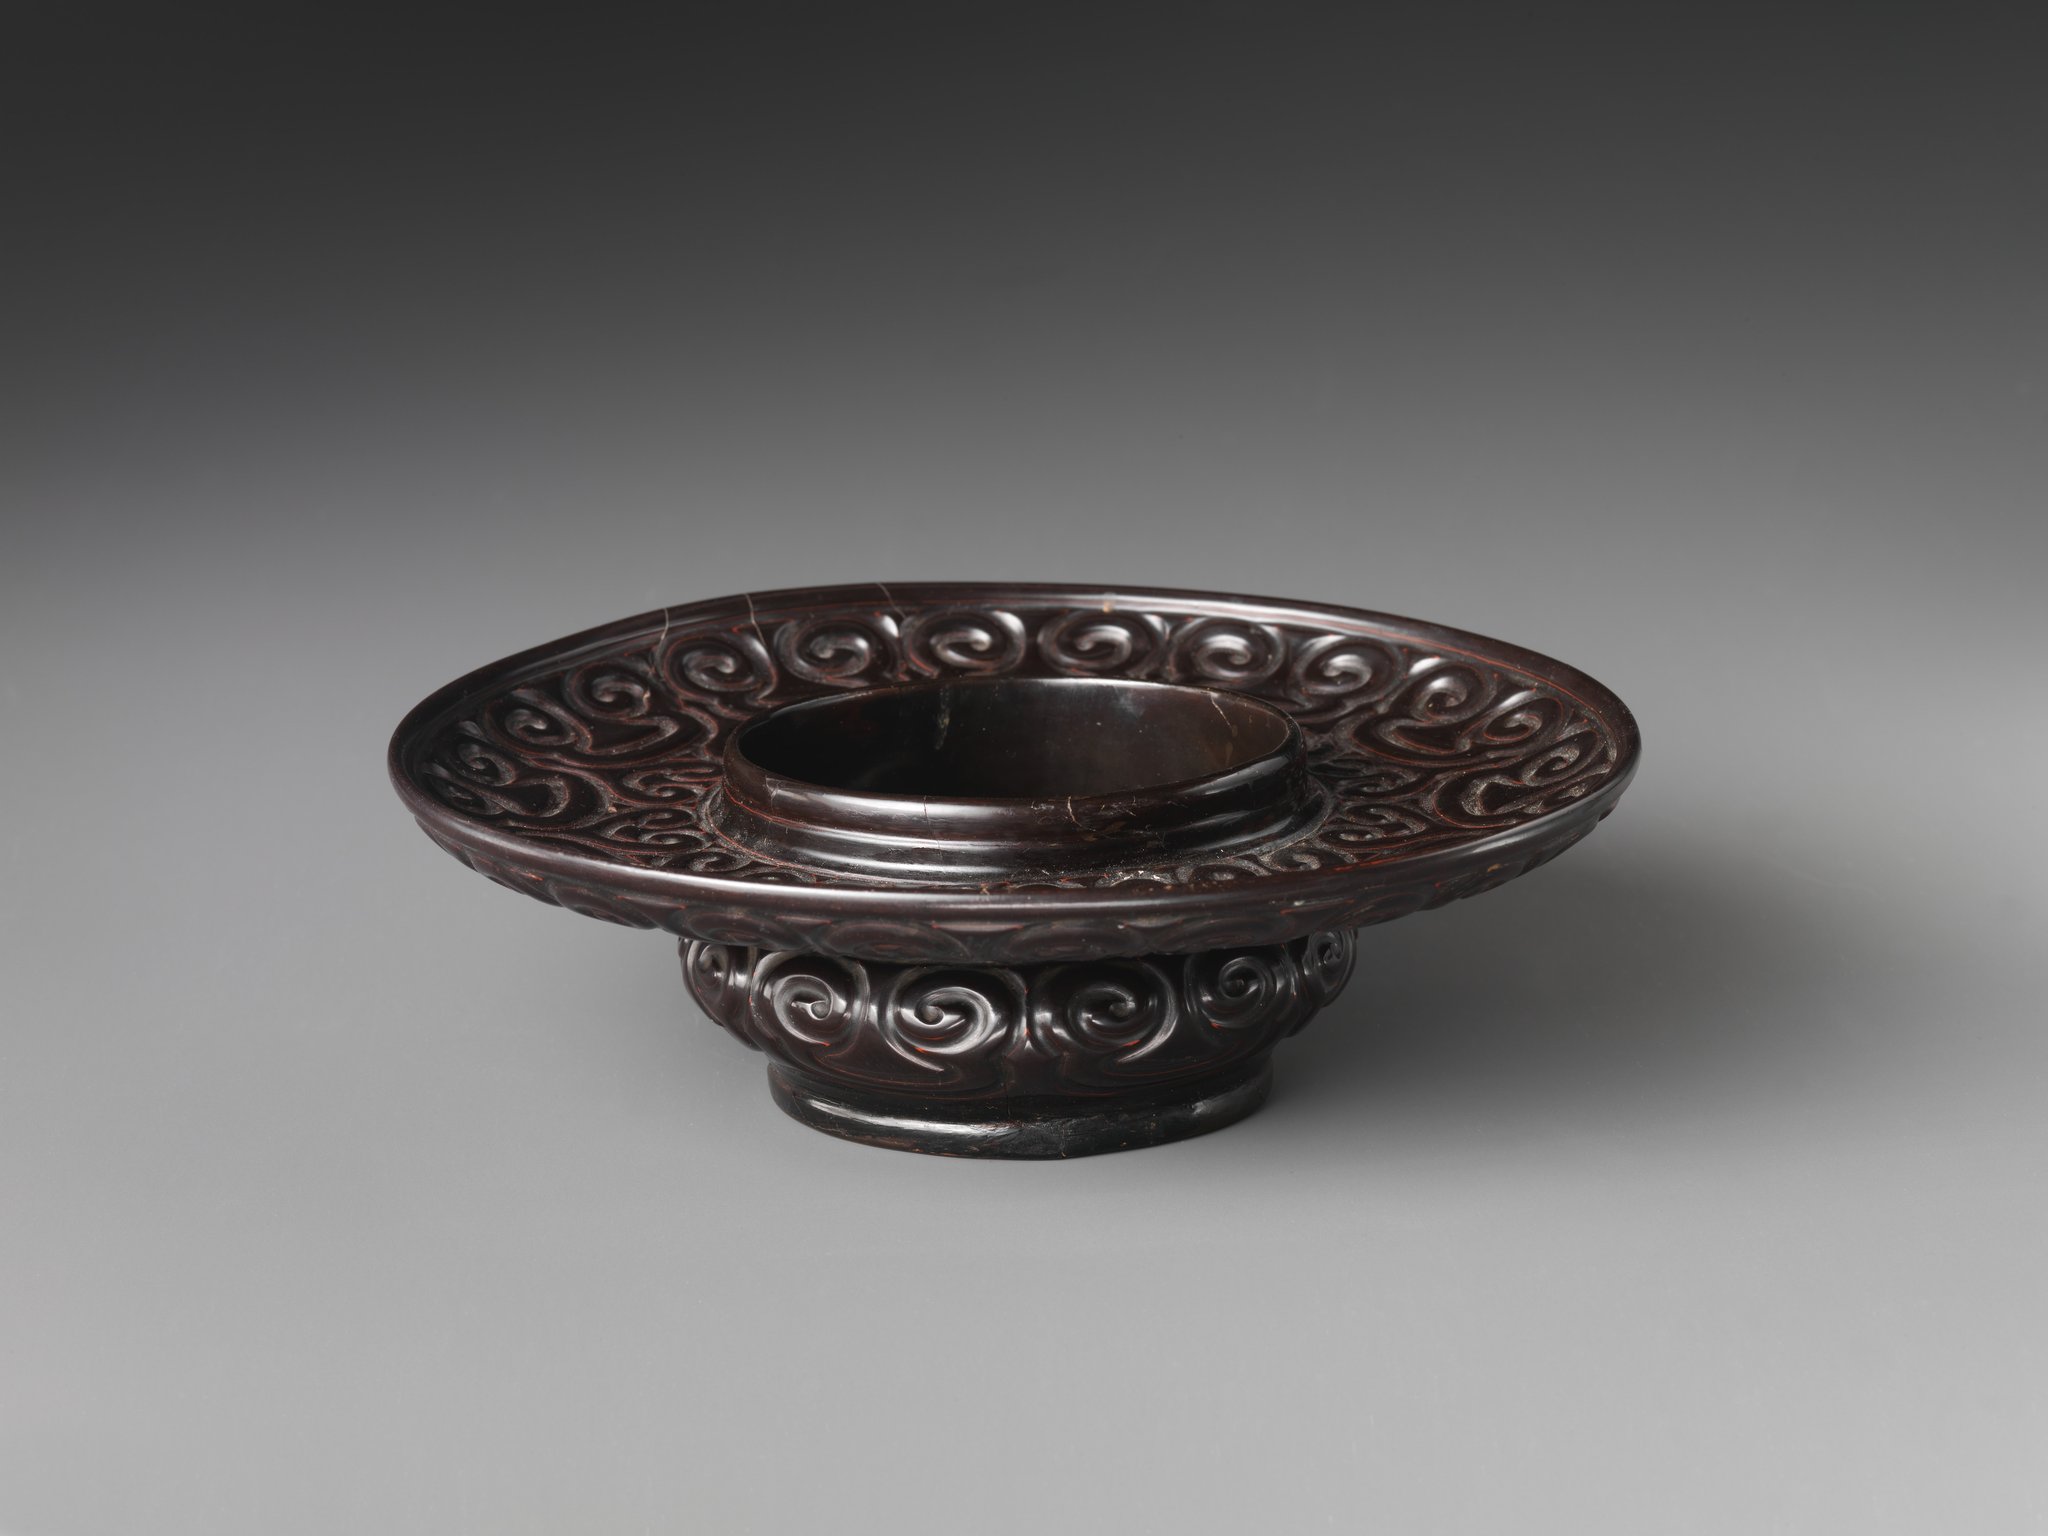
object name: cupstand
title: Guri cupstand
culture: chinese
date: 1368-1644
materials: lacquer